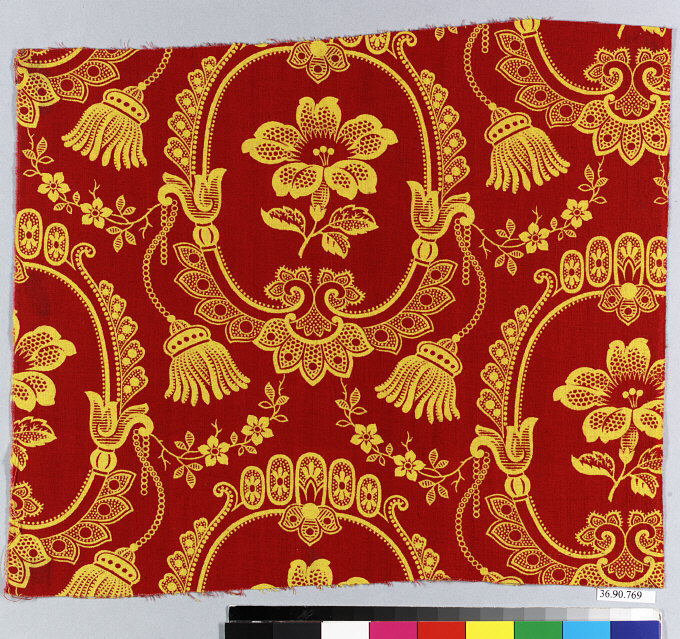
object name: piece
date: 1867-1900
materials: cotton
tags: flowers,leaves